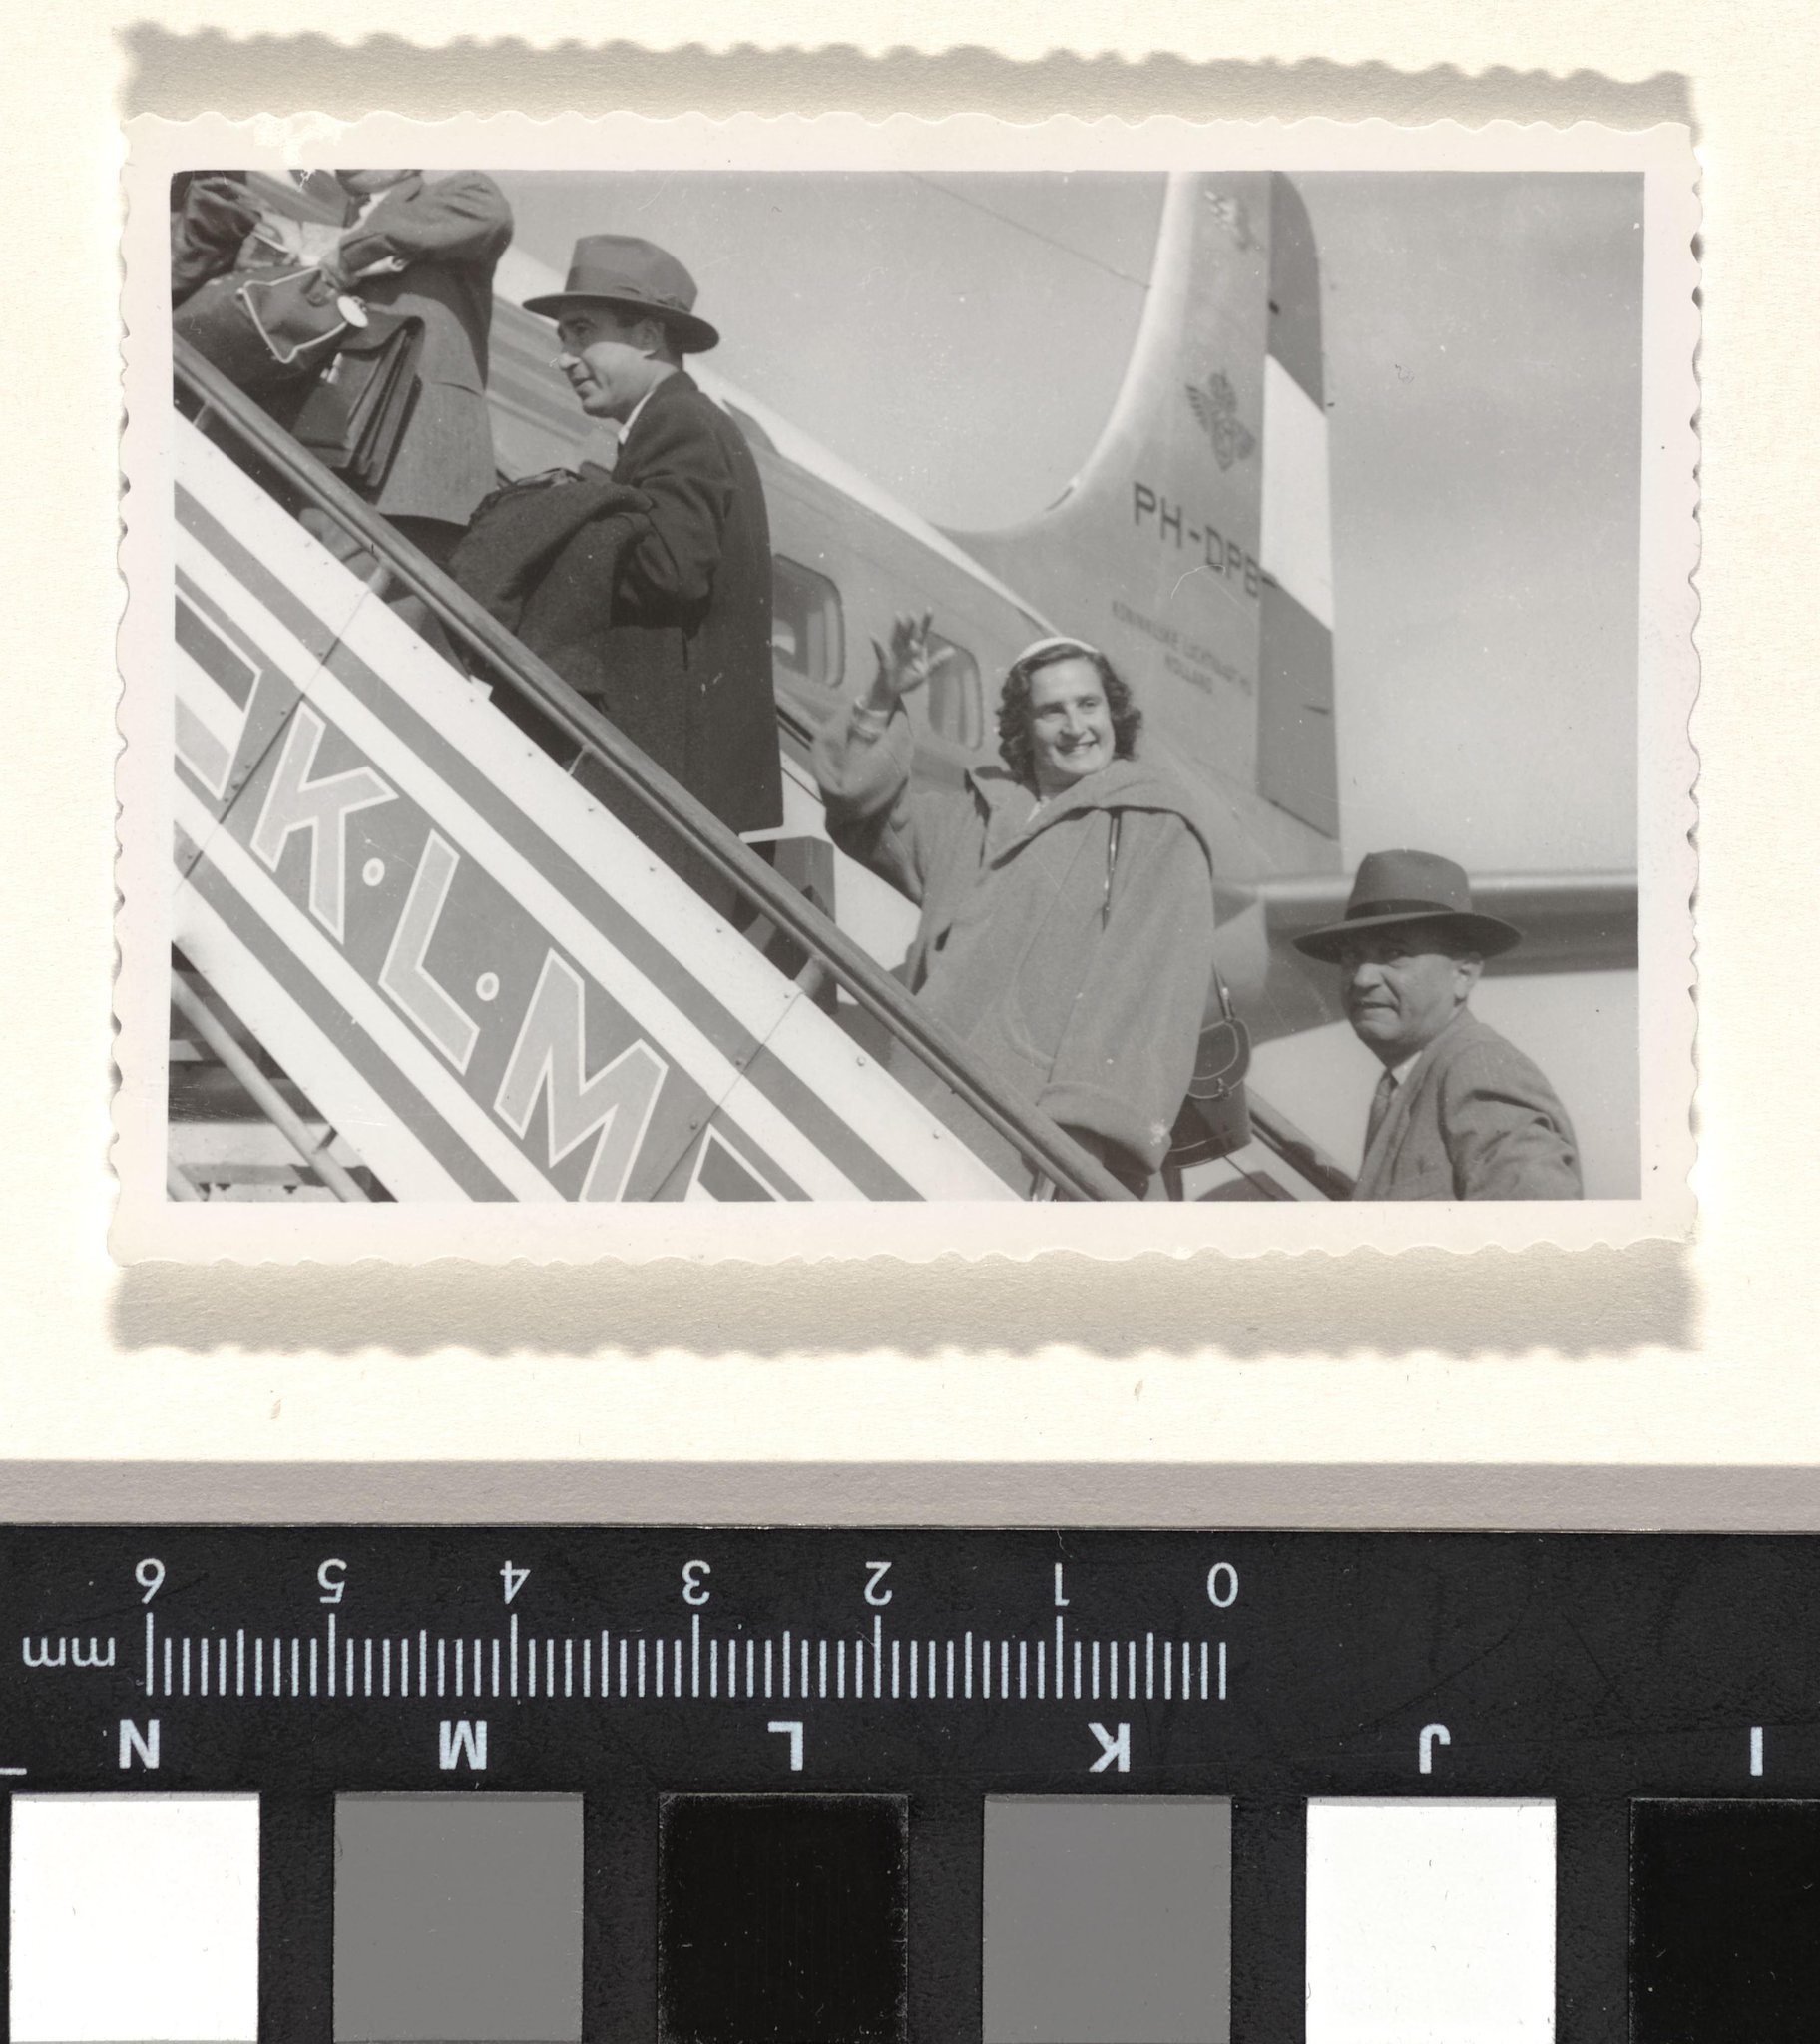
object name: photograph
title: Isabel Wachenheimer zwaaiend op de toegangstrap van een KLM-toestel met onbekende mannen met een hoed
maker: Anonymous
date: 1947-1955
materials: photographic support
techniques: gelatin silver print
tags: isabel wachenheimer-elon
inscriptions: number: ‘6 (NB, onderstreept)’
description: Isabel Wachenheimer zwaaiend op de toegangstrap van een KLM-toestel met onbekende mannen met een hoed.